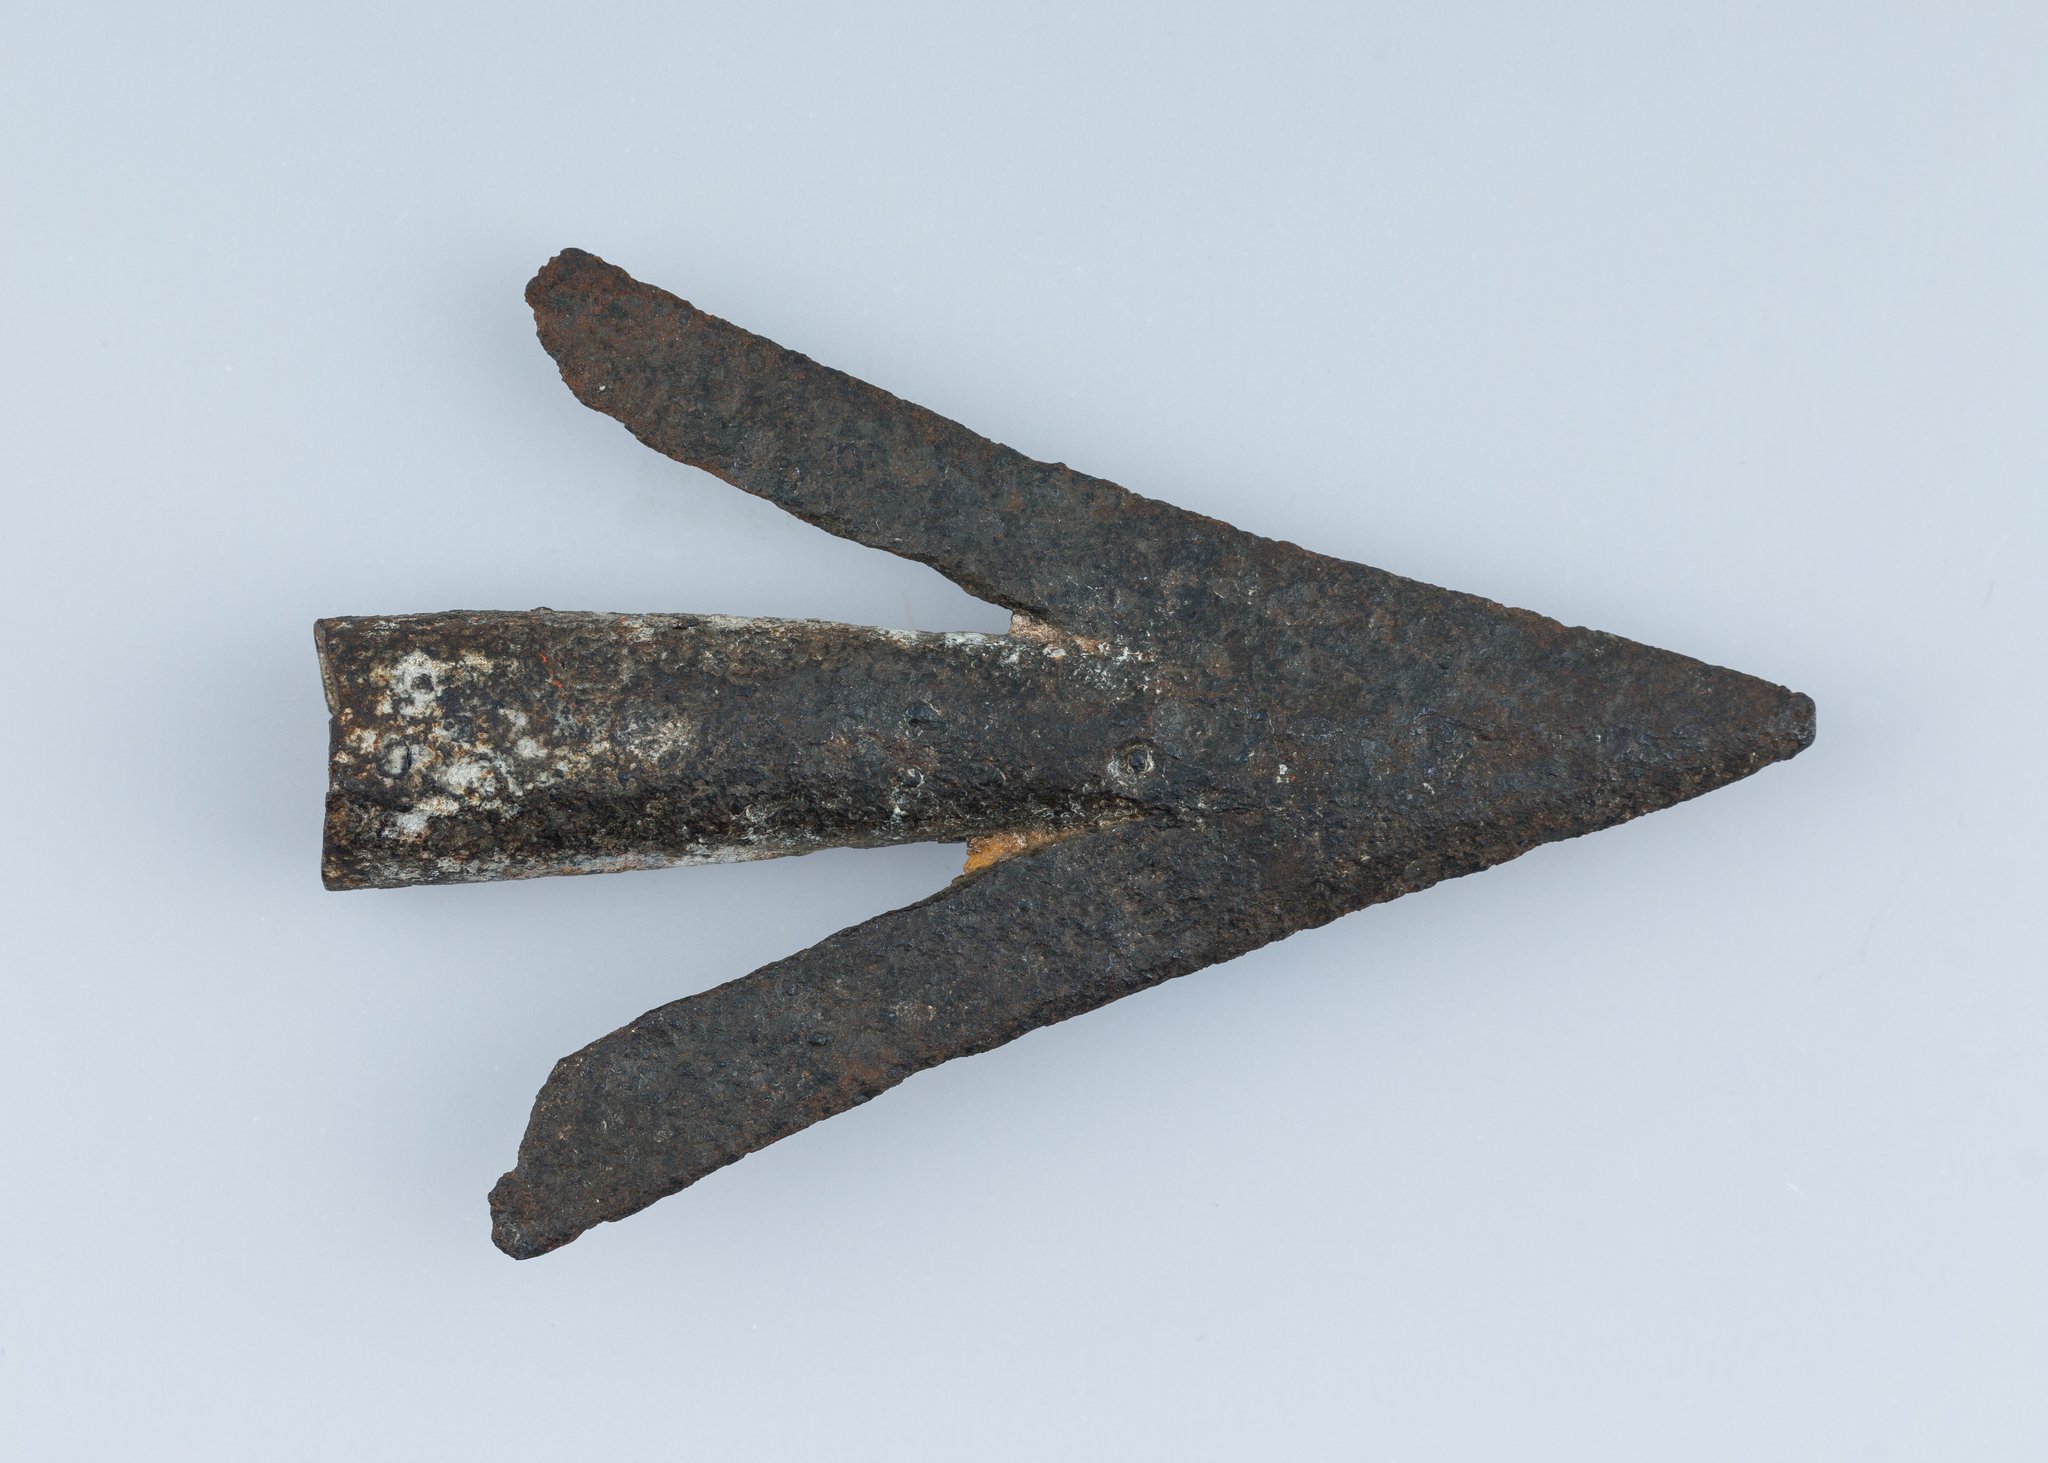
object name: arrow head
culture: spanish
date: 1501-1600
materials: iron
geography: spain